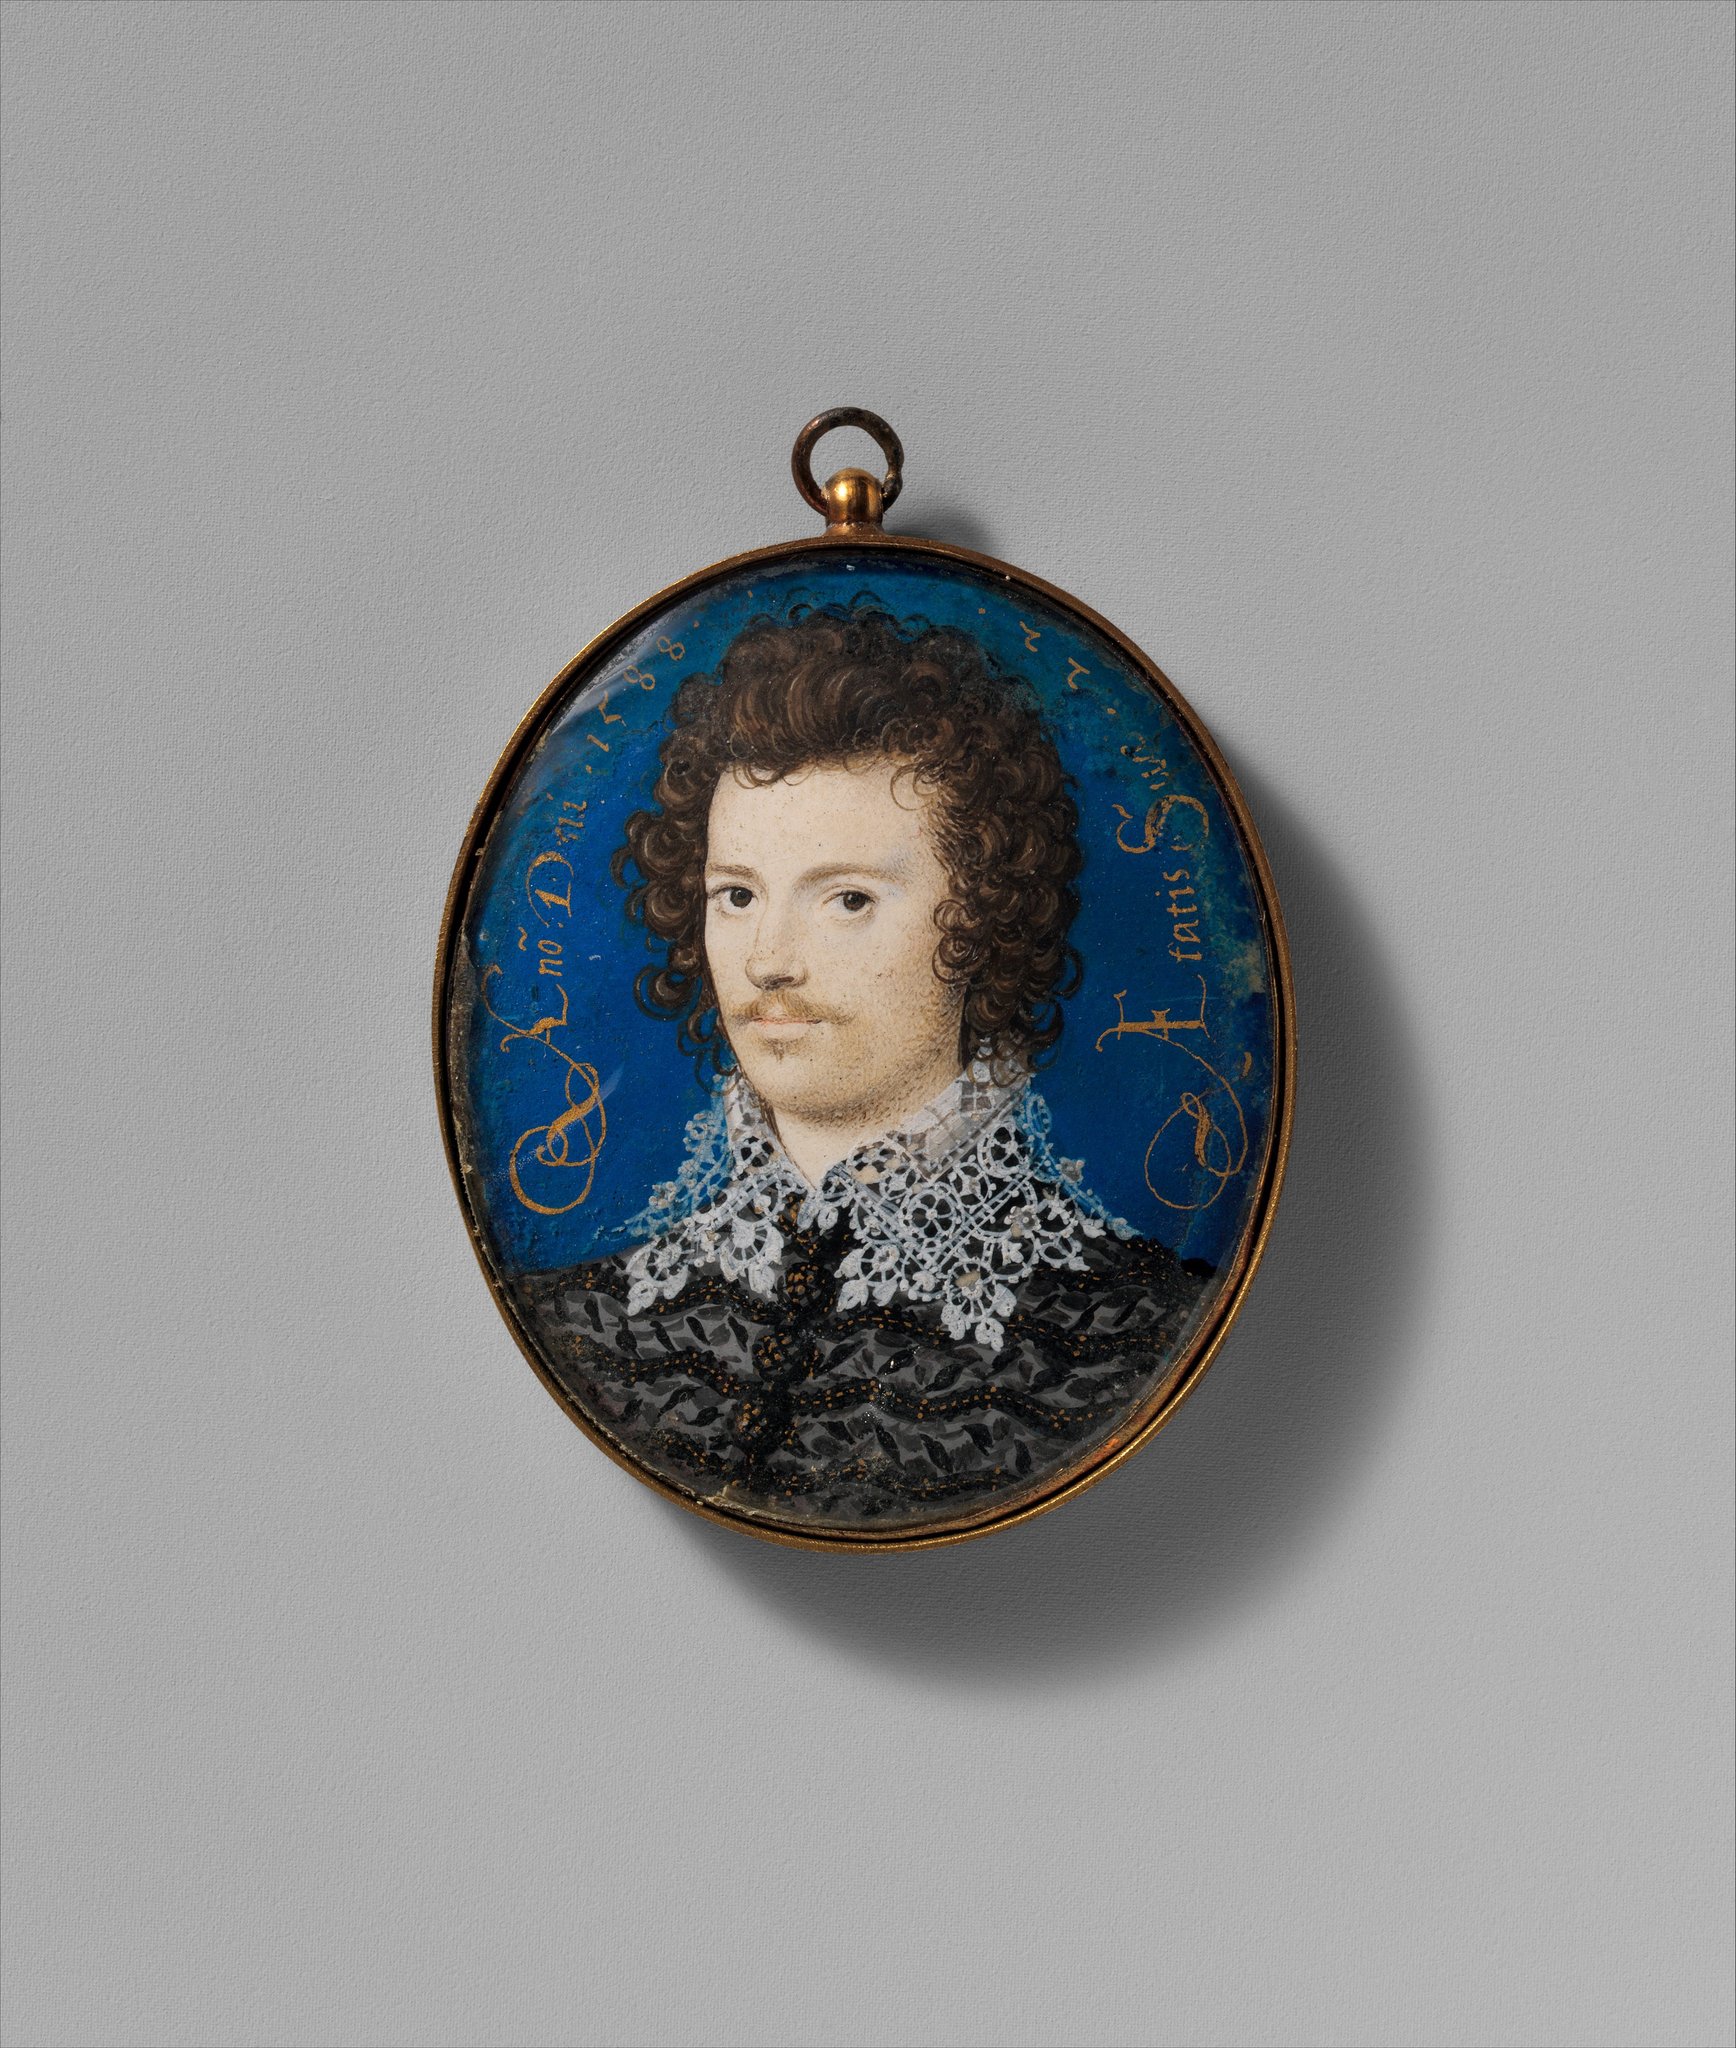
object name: painting, miniature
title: Portrait of a Young Man, Probably Robert Devereux (1566–1601), Second Earl of Essex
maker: nicholas hilliard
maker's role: artist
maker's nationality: british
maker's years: 1542-1619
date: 1588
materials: parchment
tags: men,portraits